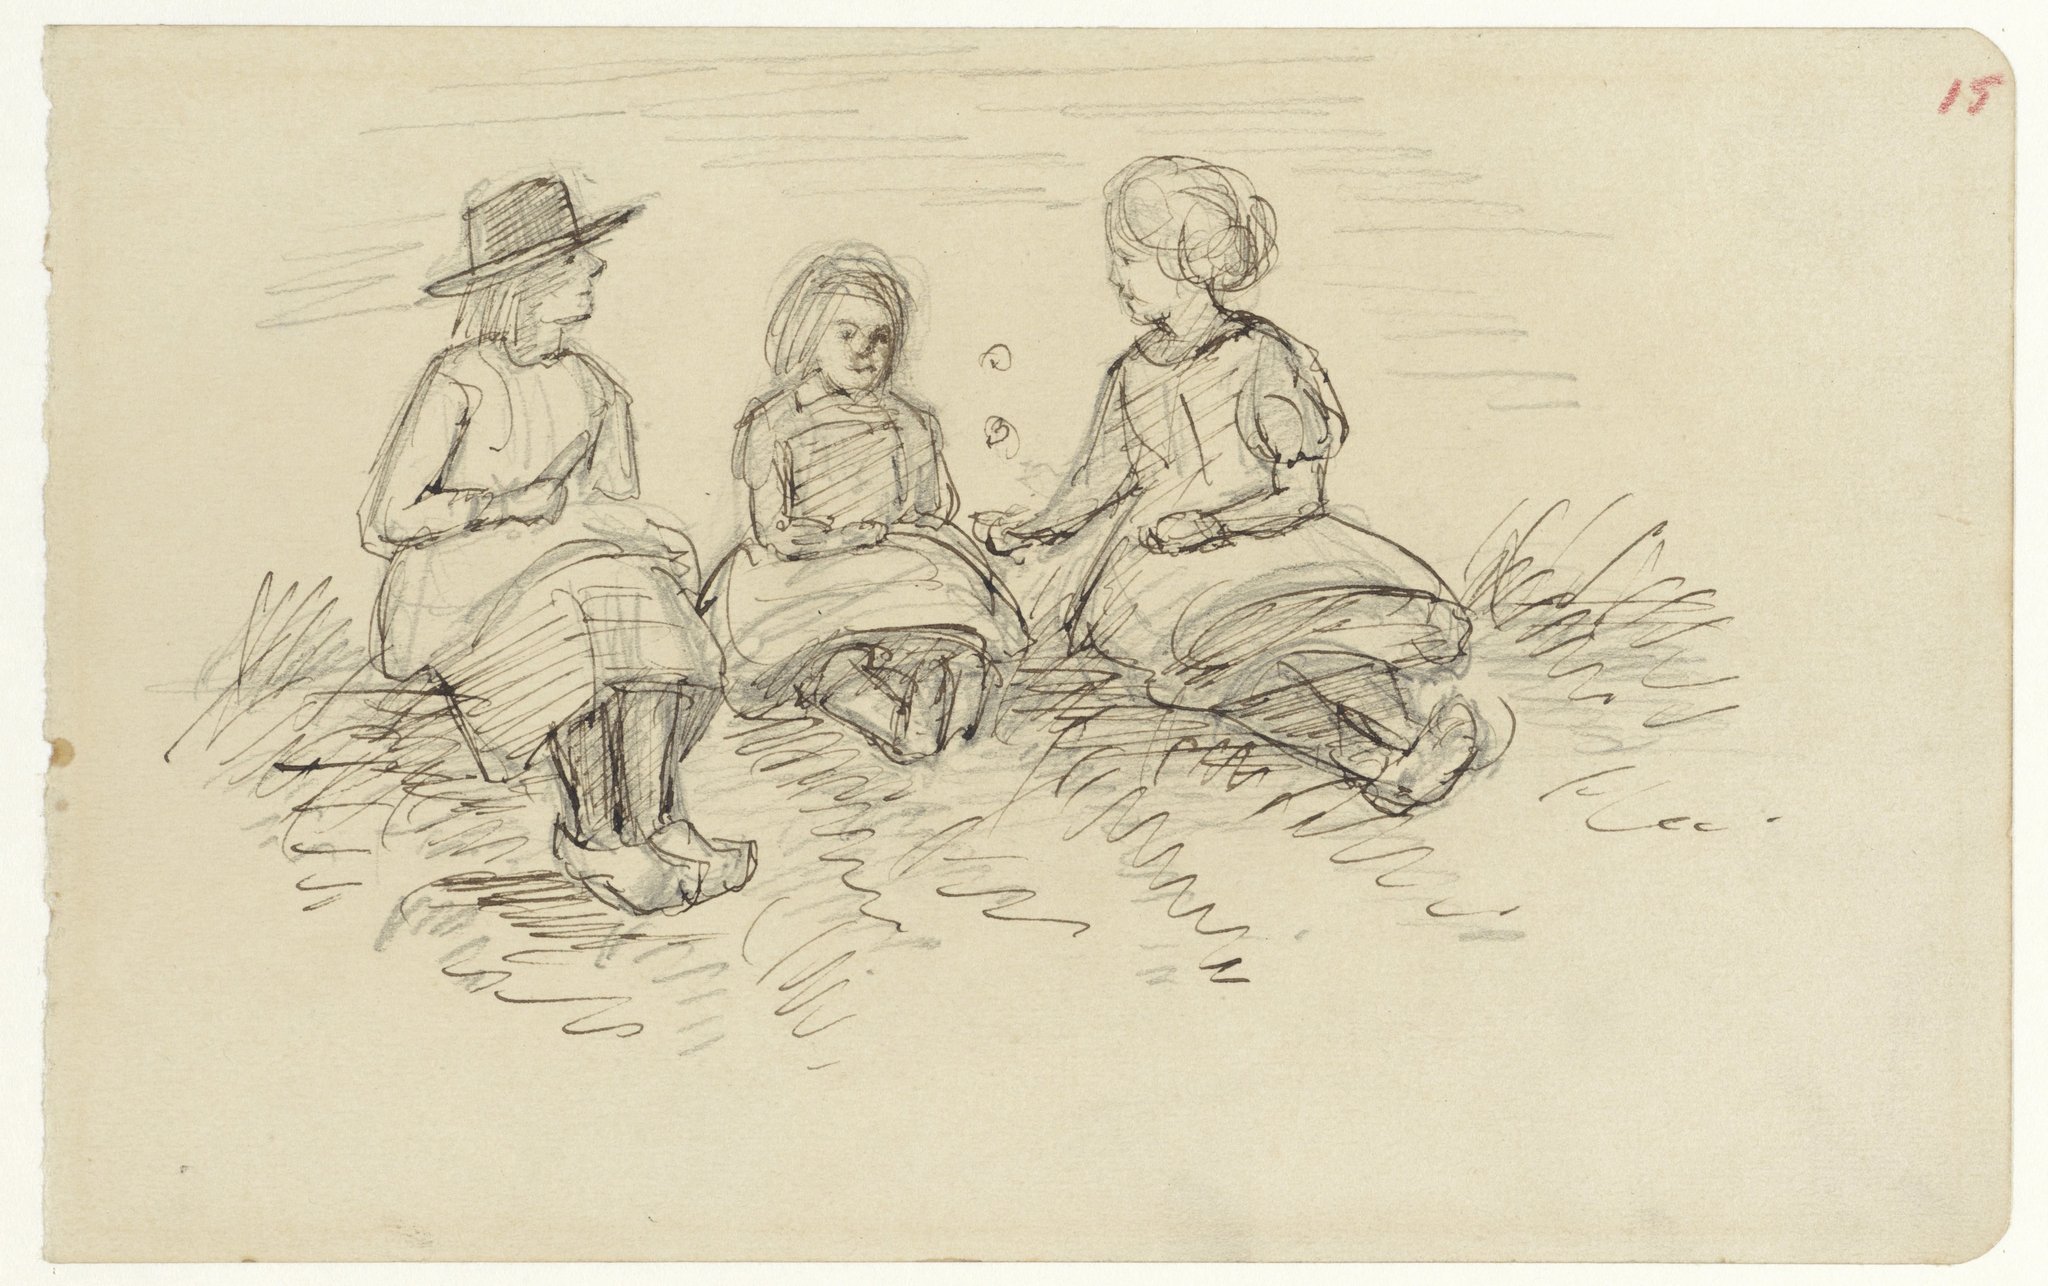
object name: drawing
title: Drie zittende kinderen in het gras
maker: jozef israëls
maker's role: draughtsman, painter, print maker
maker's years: 1824-1911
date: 1834-1911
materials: ink, paper, pencil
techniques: pen